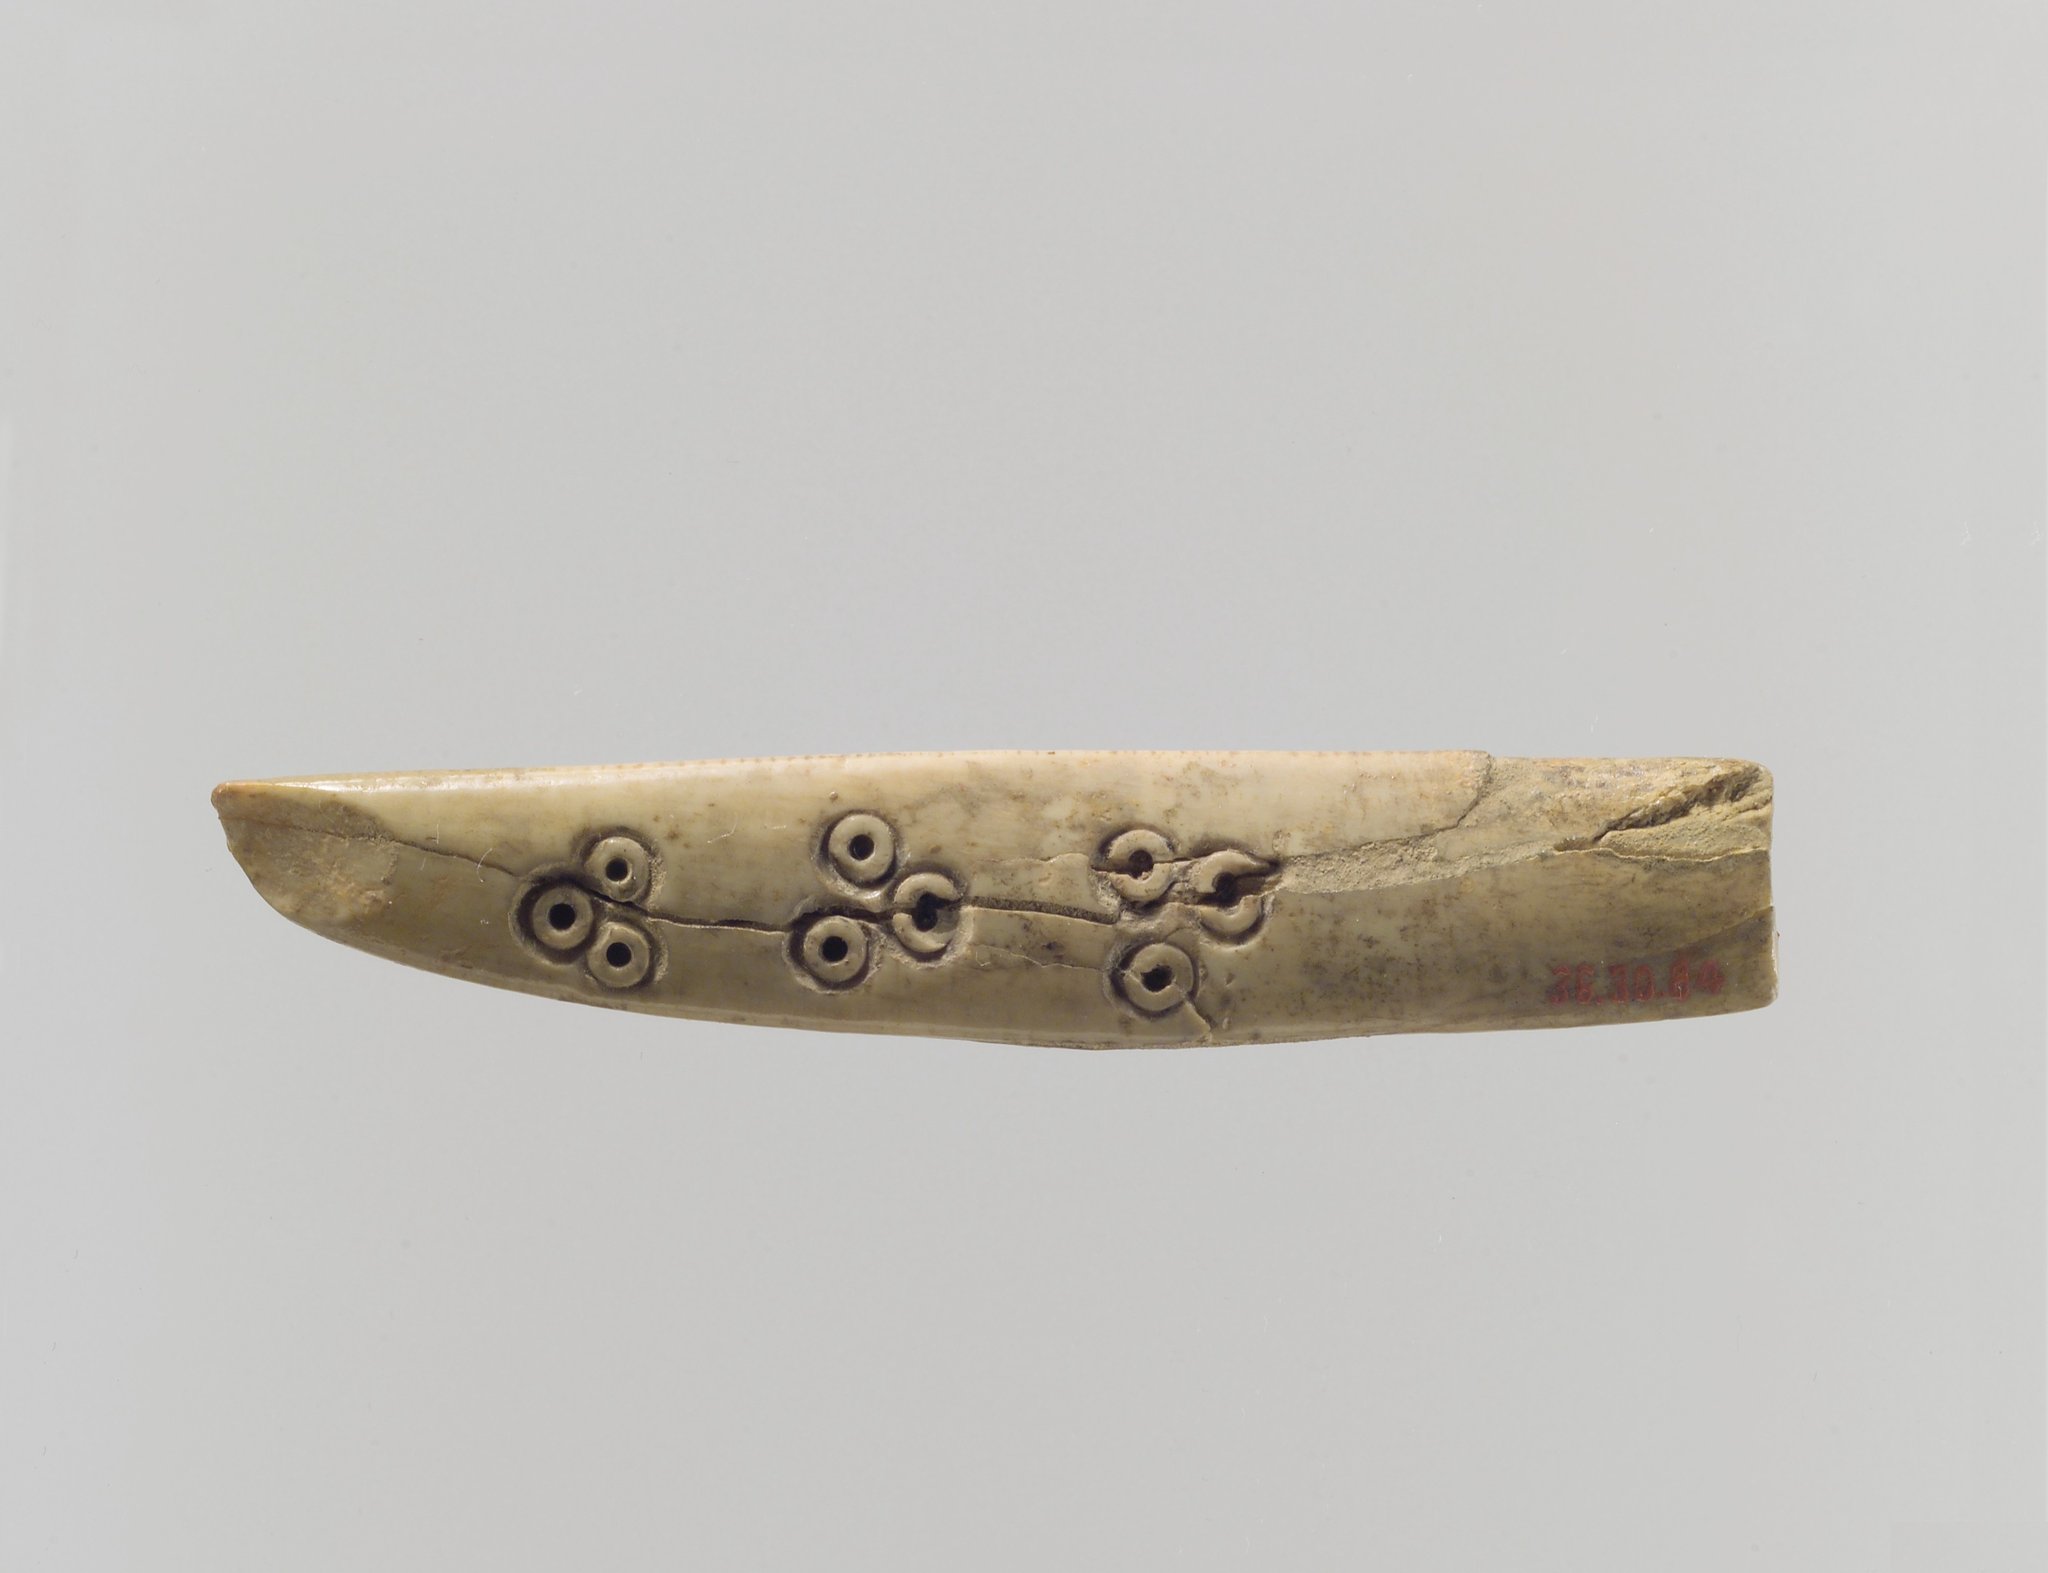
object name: handle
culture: sasanian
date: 201-700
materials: ivory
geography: iran